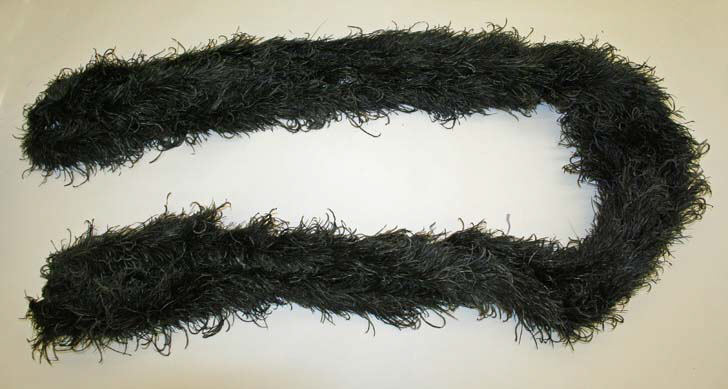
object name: boa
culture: american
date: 1890-1900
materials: feather